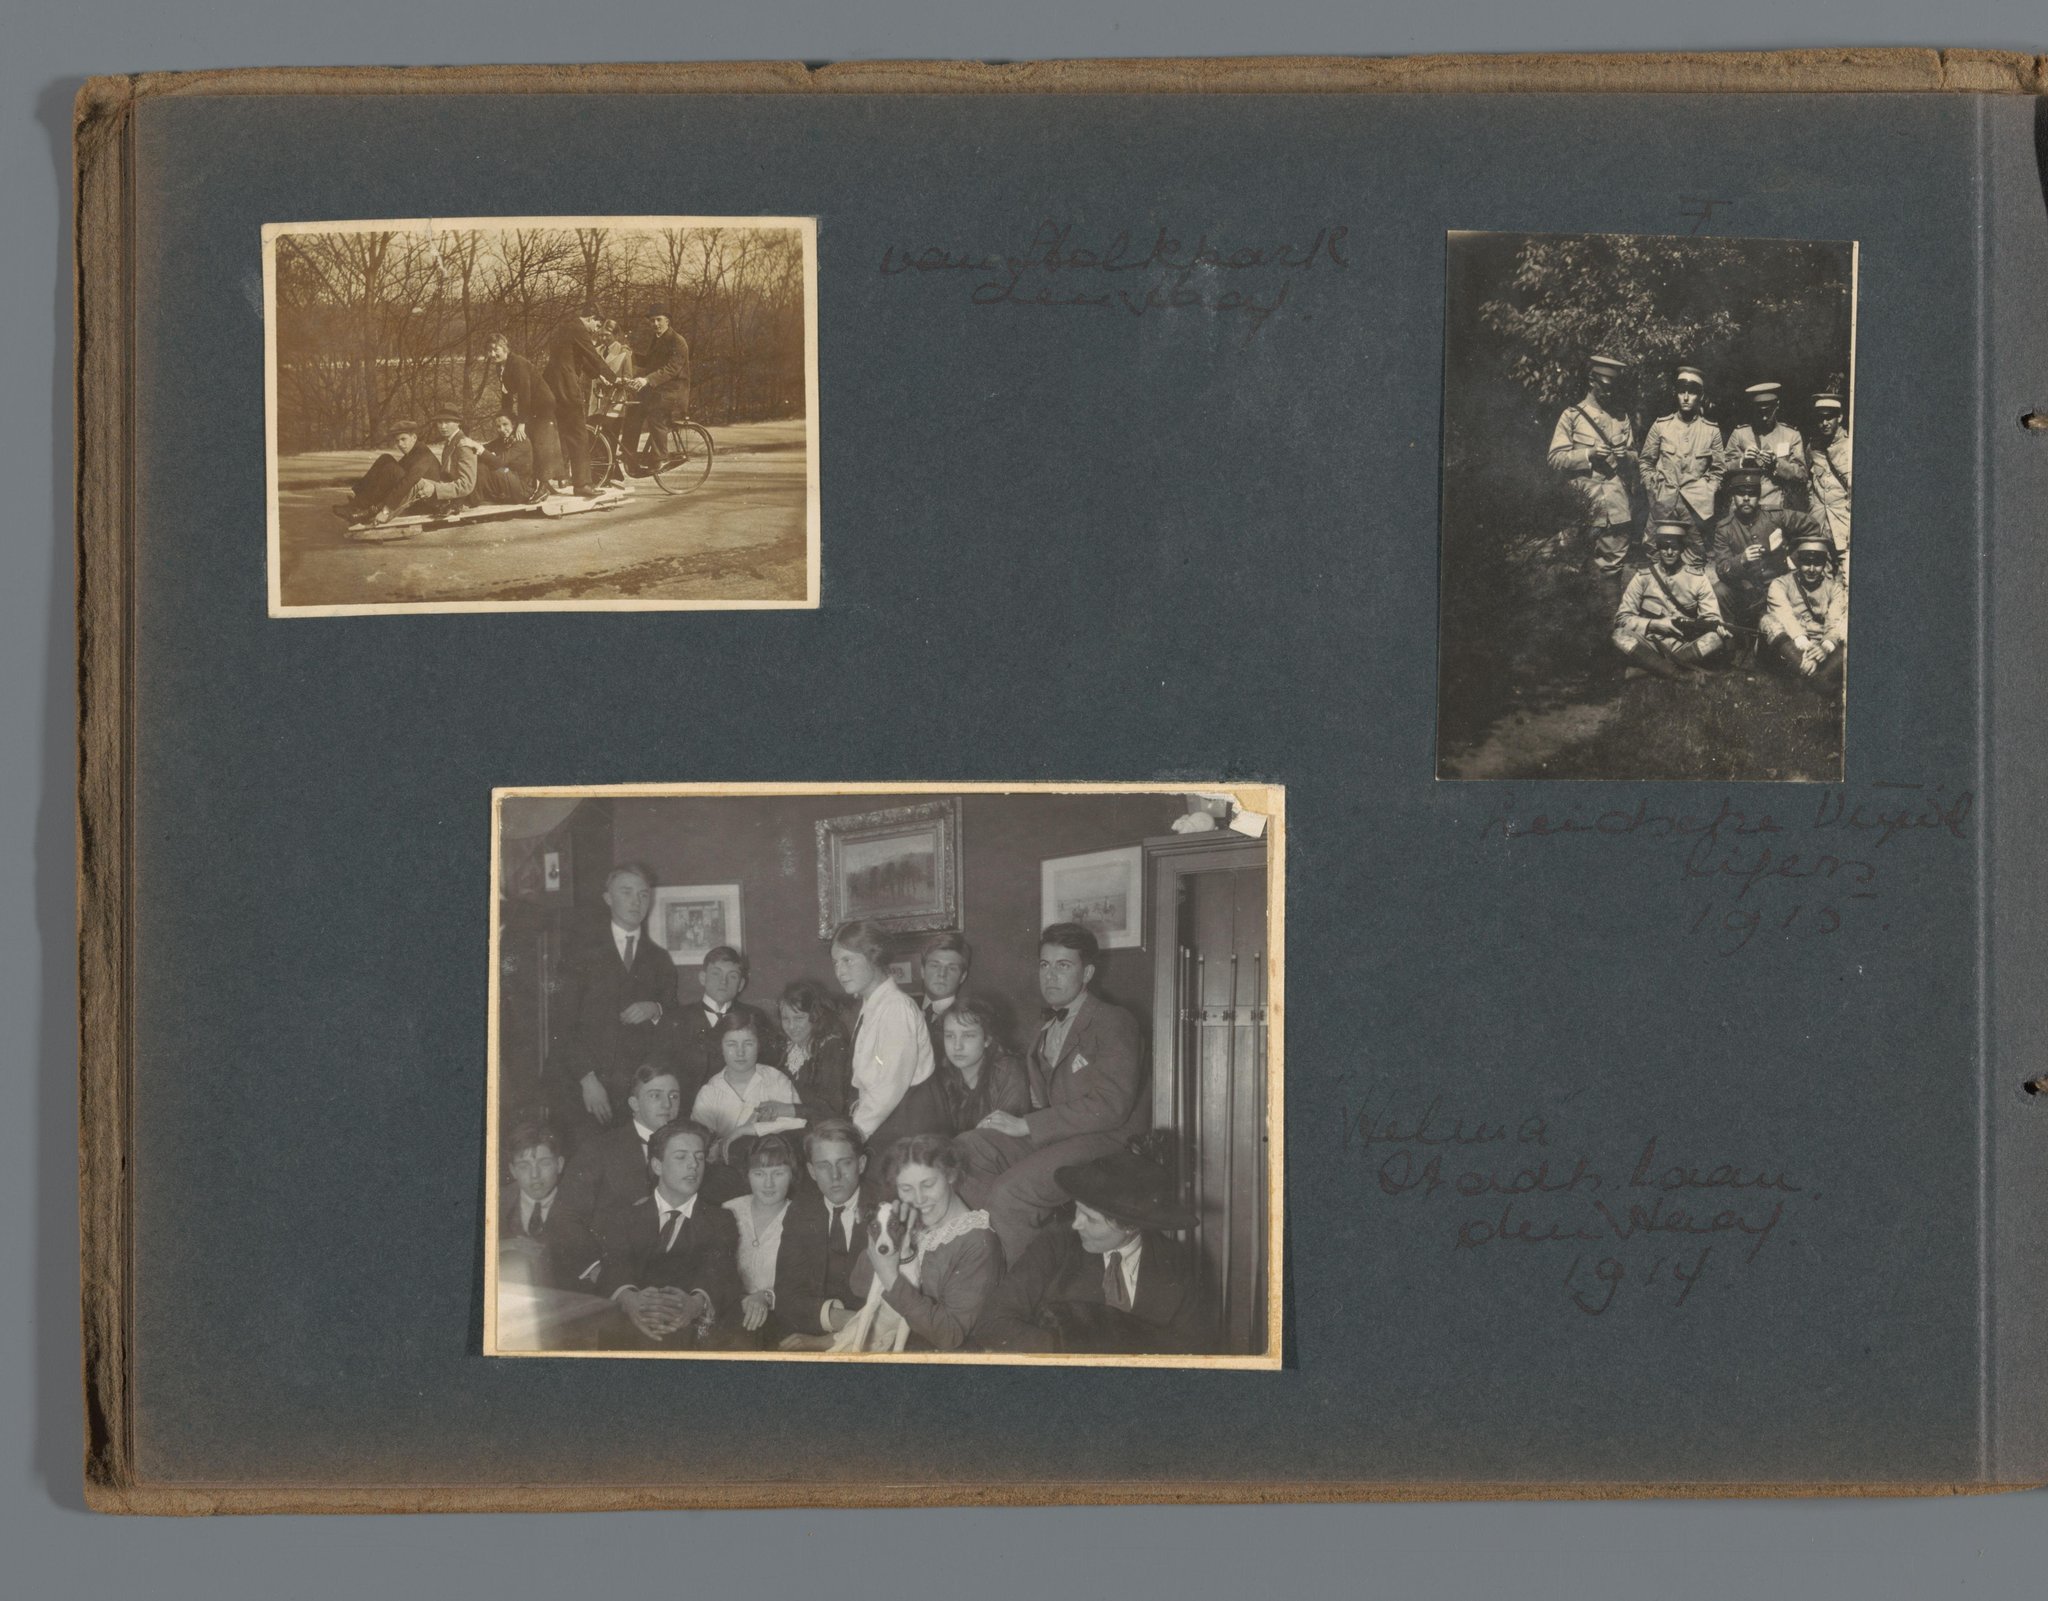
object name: photograph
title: Vriendengroep in het Van Stolkpark en in Villa Helma in Den Haag, rechtsboven een groepsportret van onbekende militairen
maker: carolina frederika onnen (lien/loen)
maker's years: 1896-1983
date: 1914-1915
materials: paper, cardboard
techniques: gelatin silver print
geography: the hague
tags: park, the soldier; the soldier's life, friends, anonymous historical persons portrayed in a group, in a group-portrait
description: Deze foto's zijn onderdeel van een album.